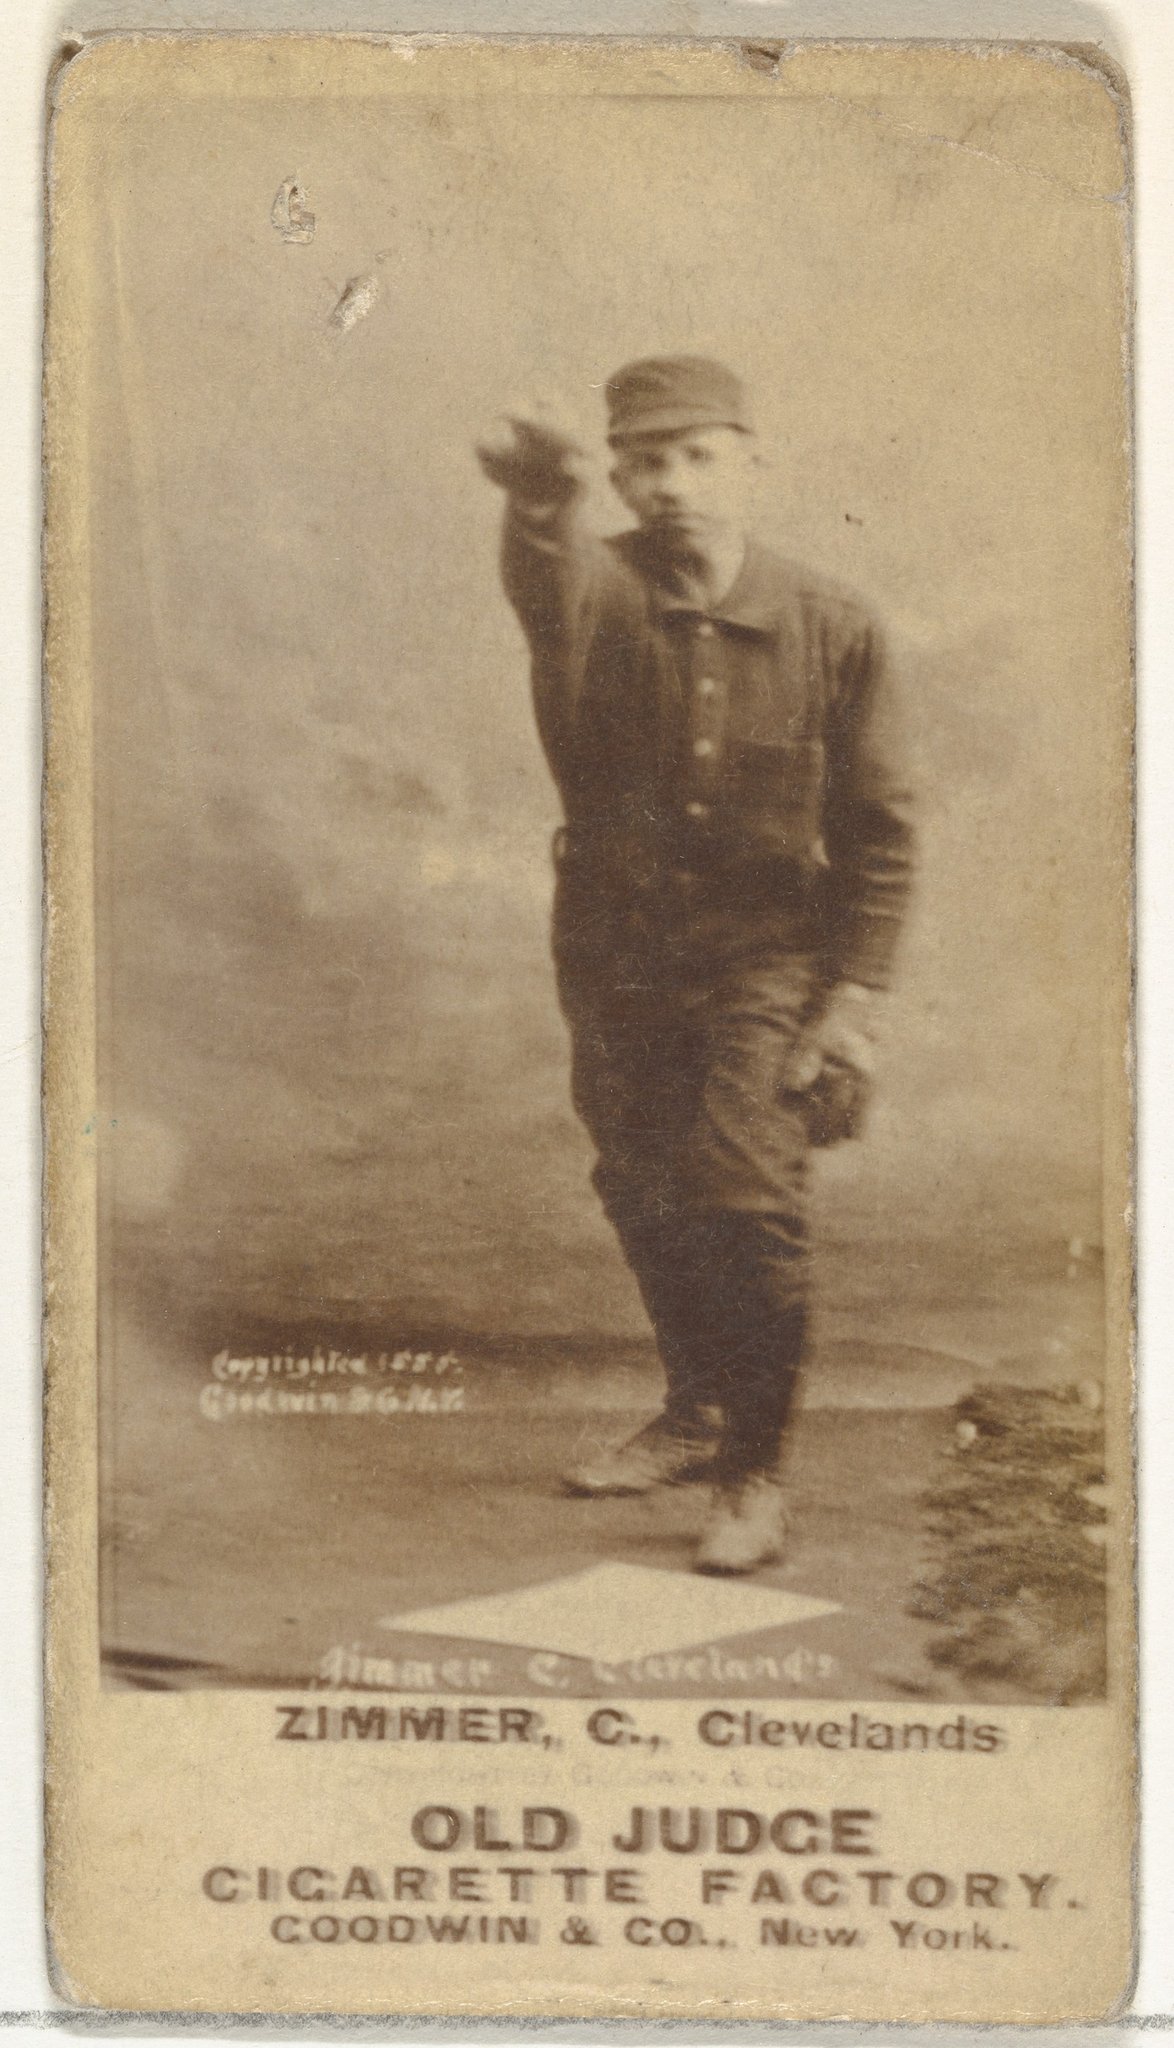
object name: baseball card, photograph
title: Charles Louis "Chief" Zimmer, Catcher, Cleveland, from the Old Judge series (N172) for Old Judge Cigarettes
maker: goodwin & company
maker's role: publisher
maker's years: 1850-1950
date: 1887-1889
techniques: albumen silver print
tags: men,portraits,baseball,athletes